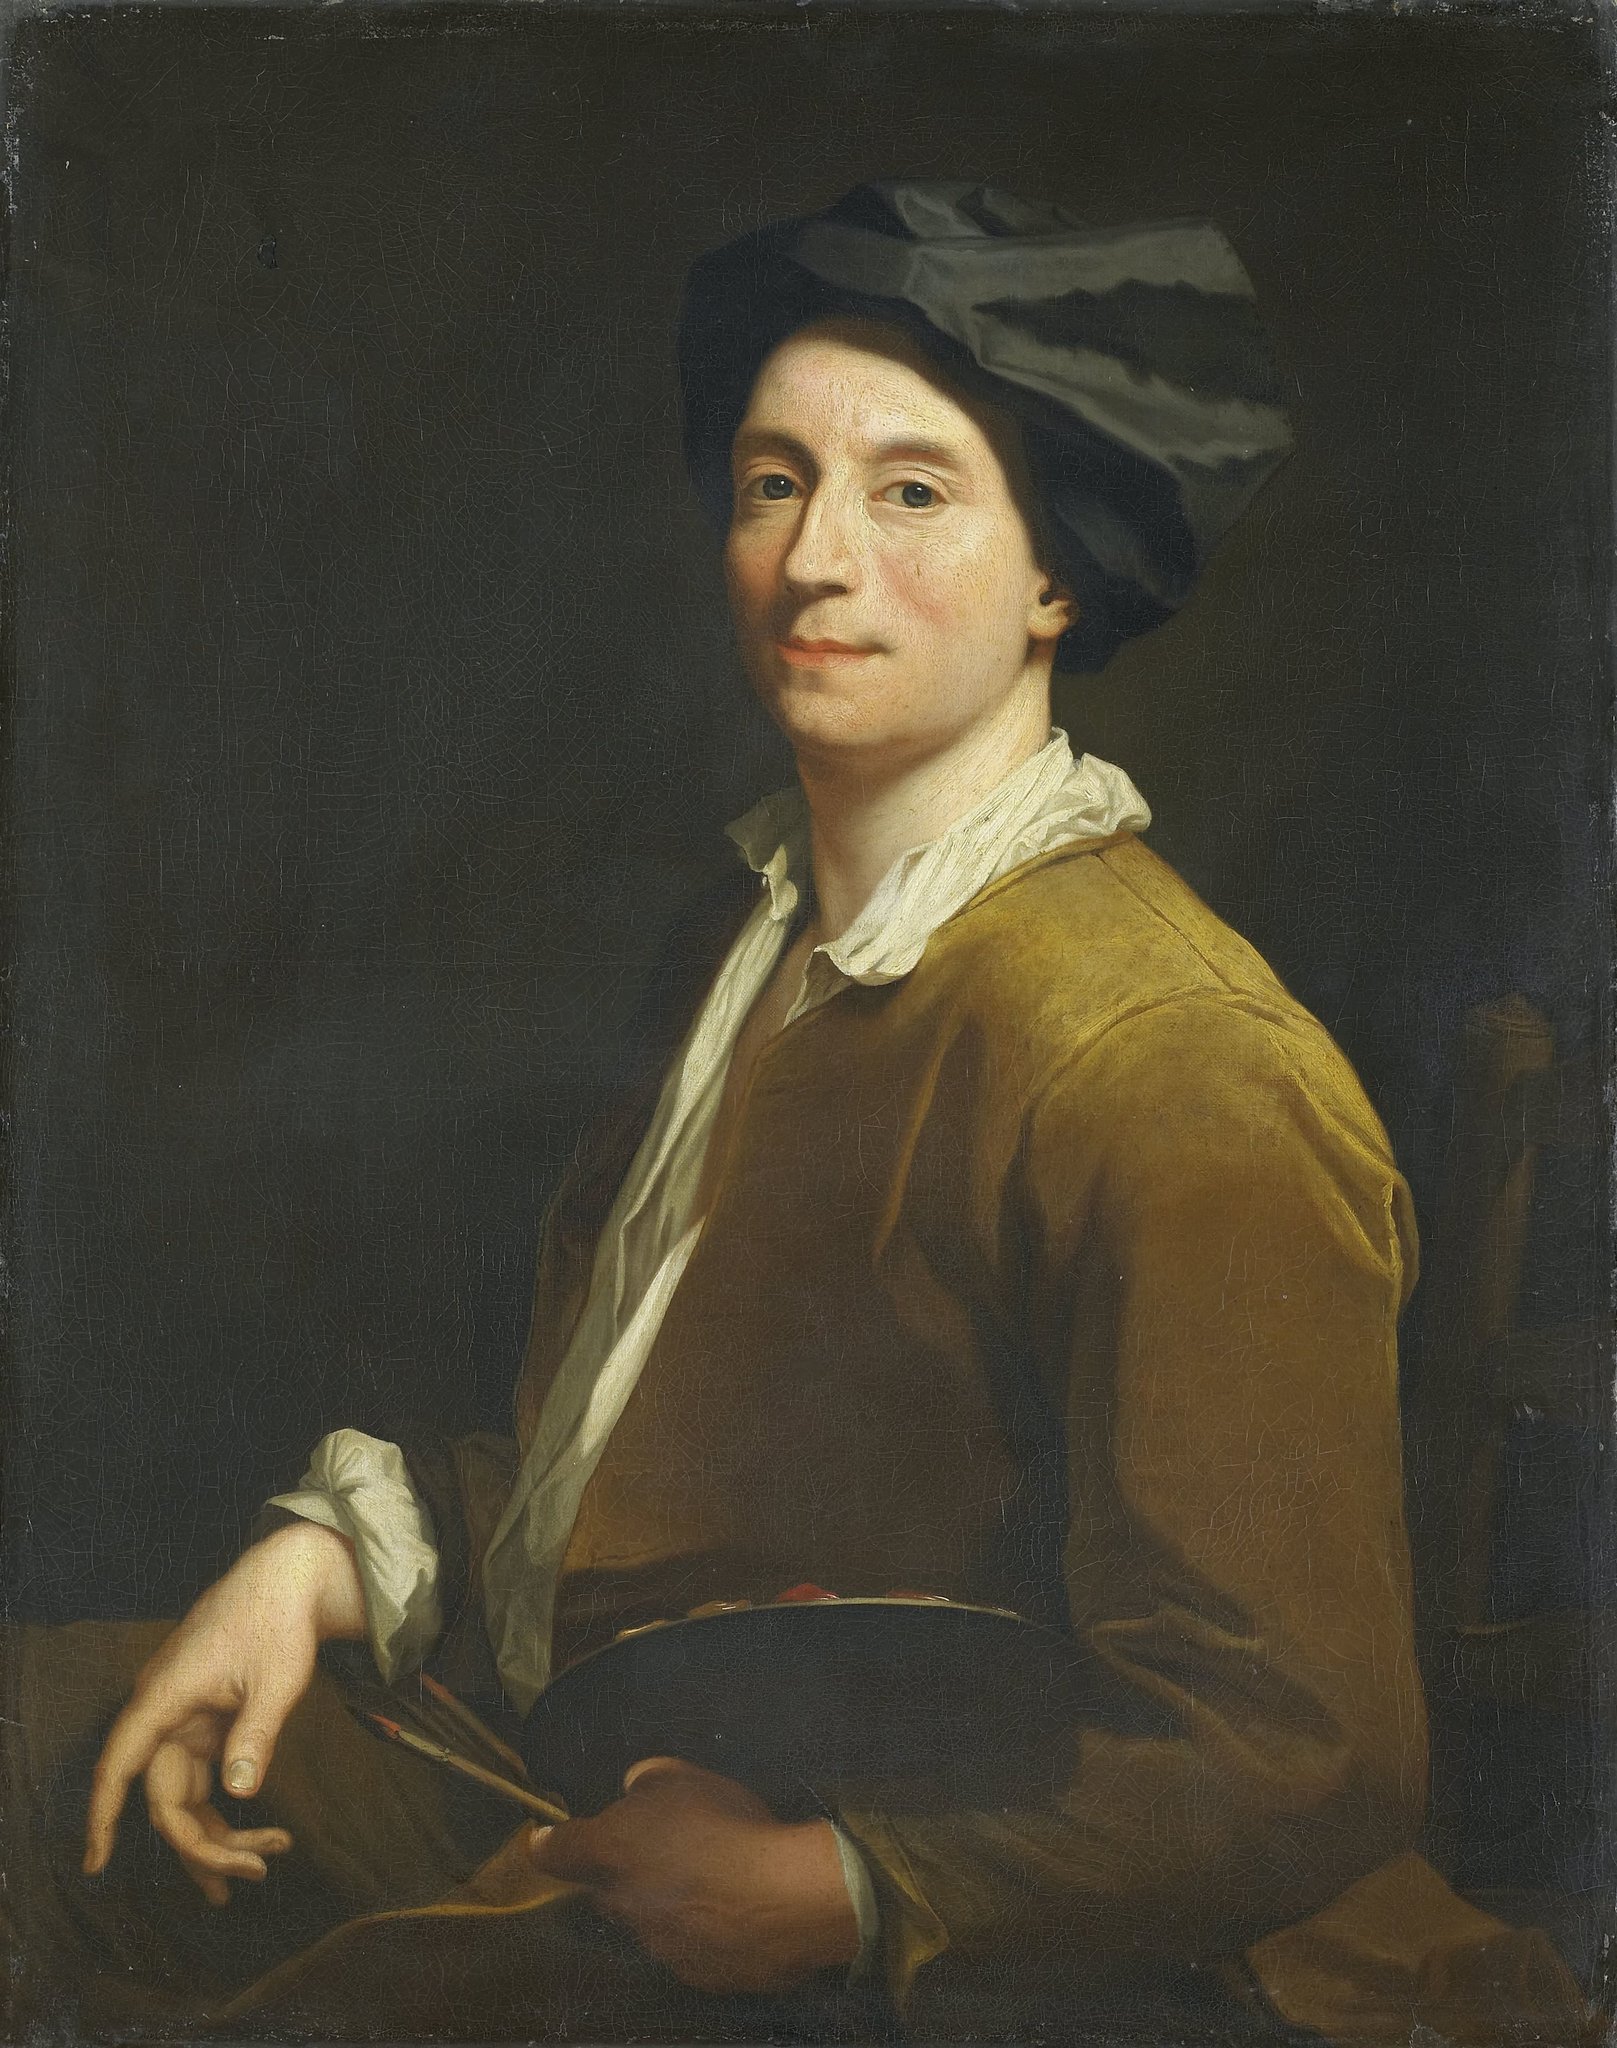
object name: painting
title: Portrait of a Painter, probably a Self Portrait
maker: christoffel lubienitzki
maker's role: draughtsman, painter, print maker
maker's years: 1659-1729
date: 1690-1729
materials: canvas, oil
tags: amsterdam, painter, print maker, draughtsman, christoffel lubienitzki, historical persons, portrait, self-portrait of artist, picture, painting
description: Portret van een schilder, vermoedelijk een zelfportret van Christoffel Lubienitzki. Ten halven lijve, zittend met palet met penselen in de linkerhand. Op het hoofd een muts.